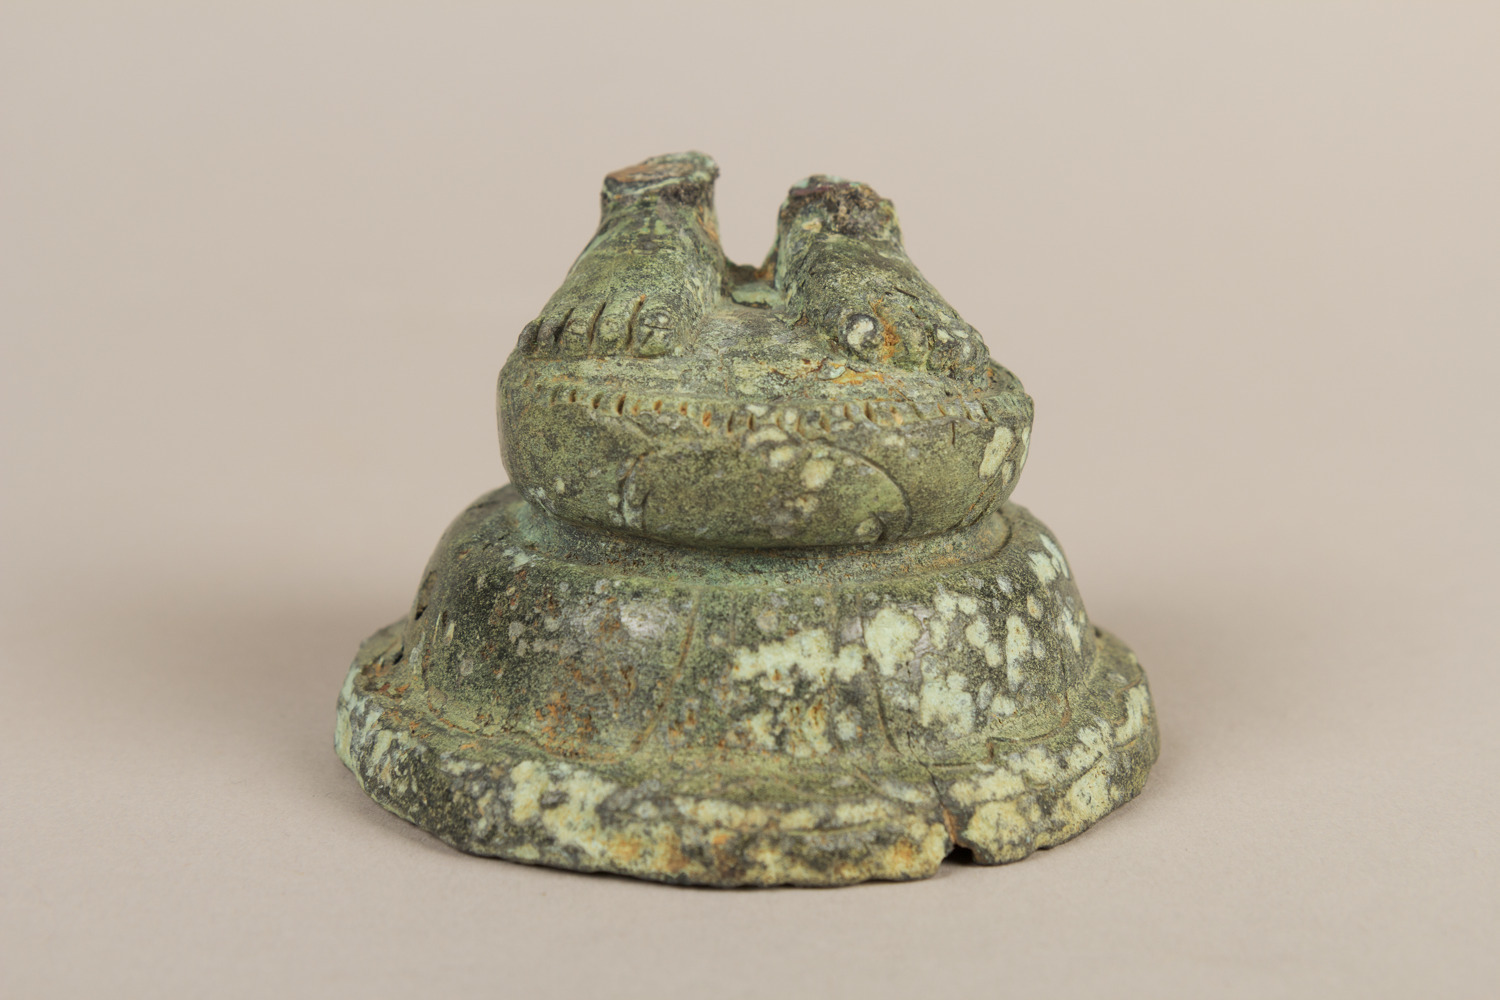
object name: fragment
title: Fragment of a Base for a Statue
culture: indonesian, kalimantan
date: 701-800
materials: bronze